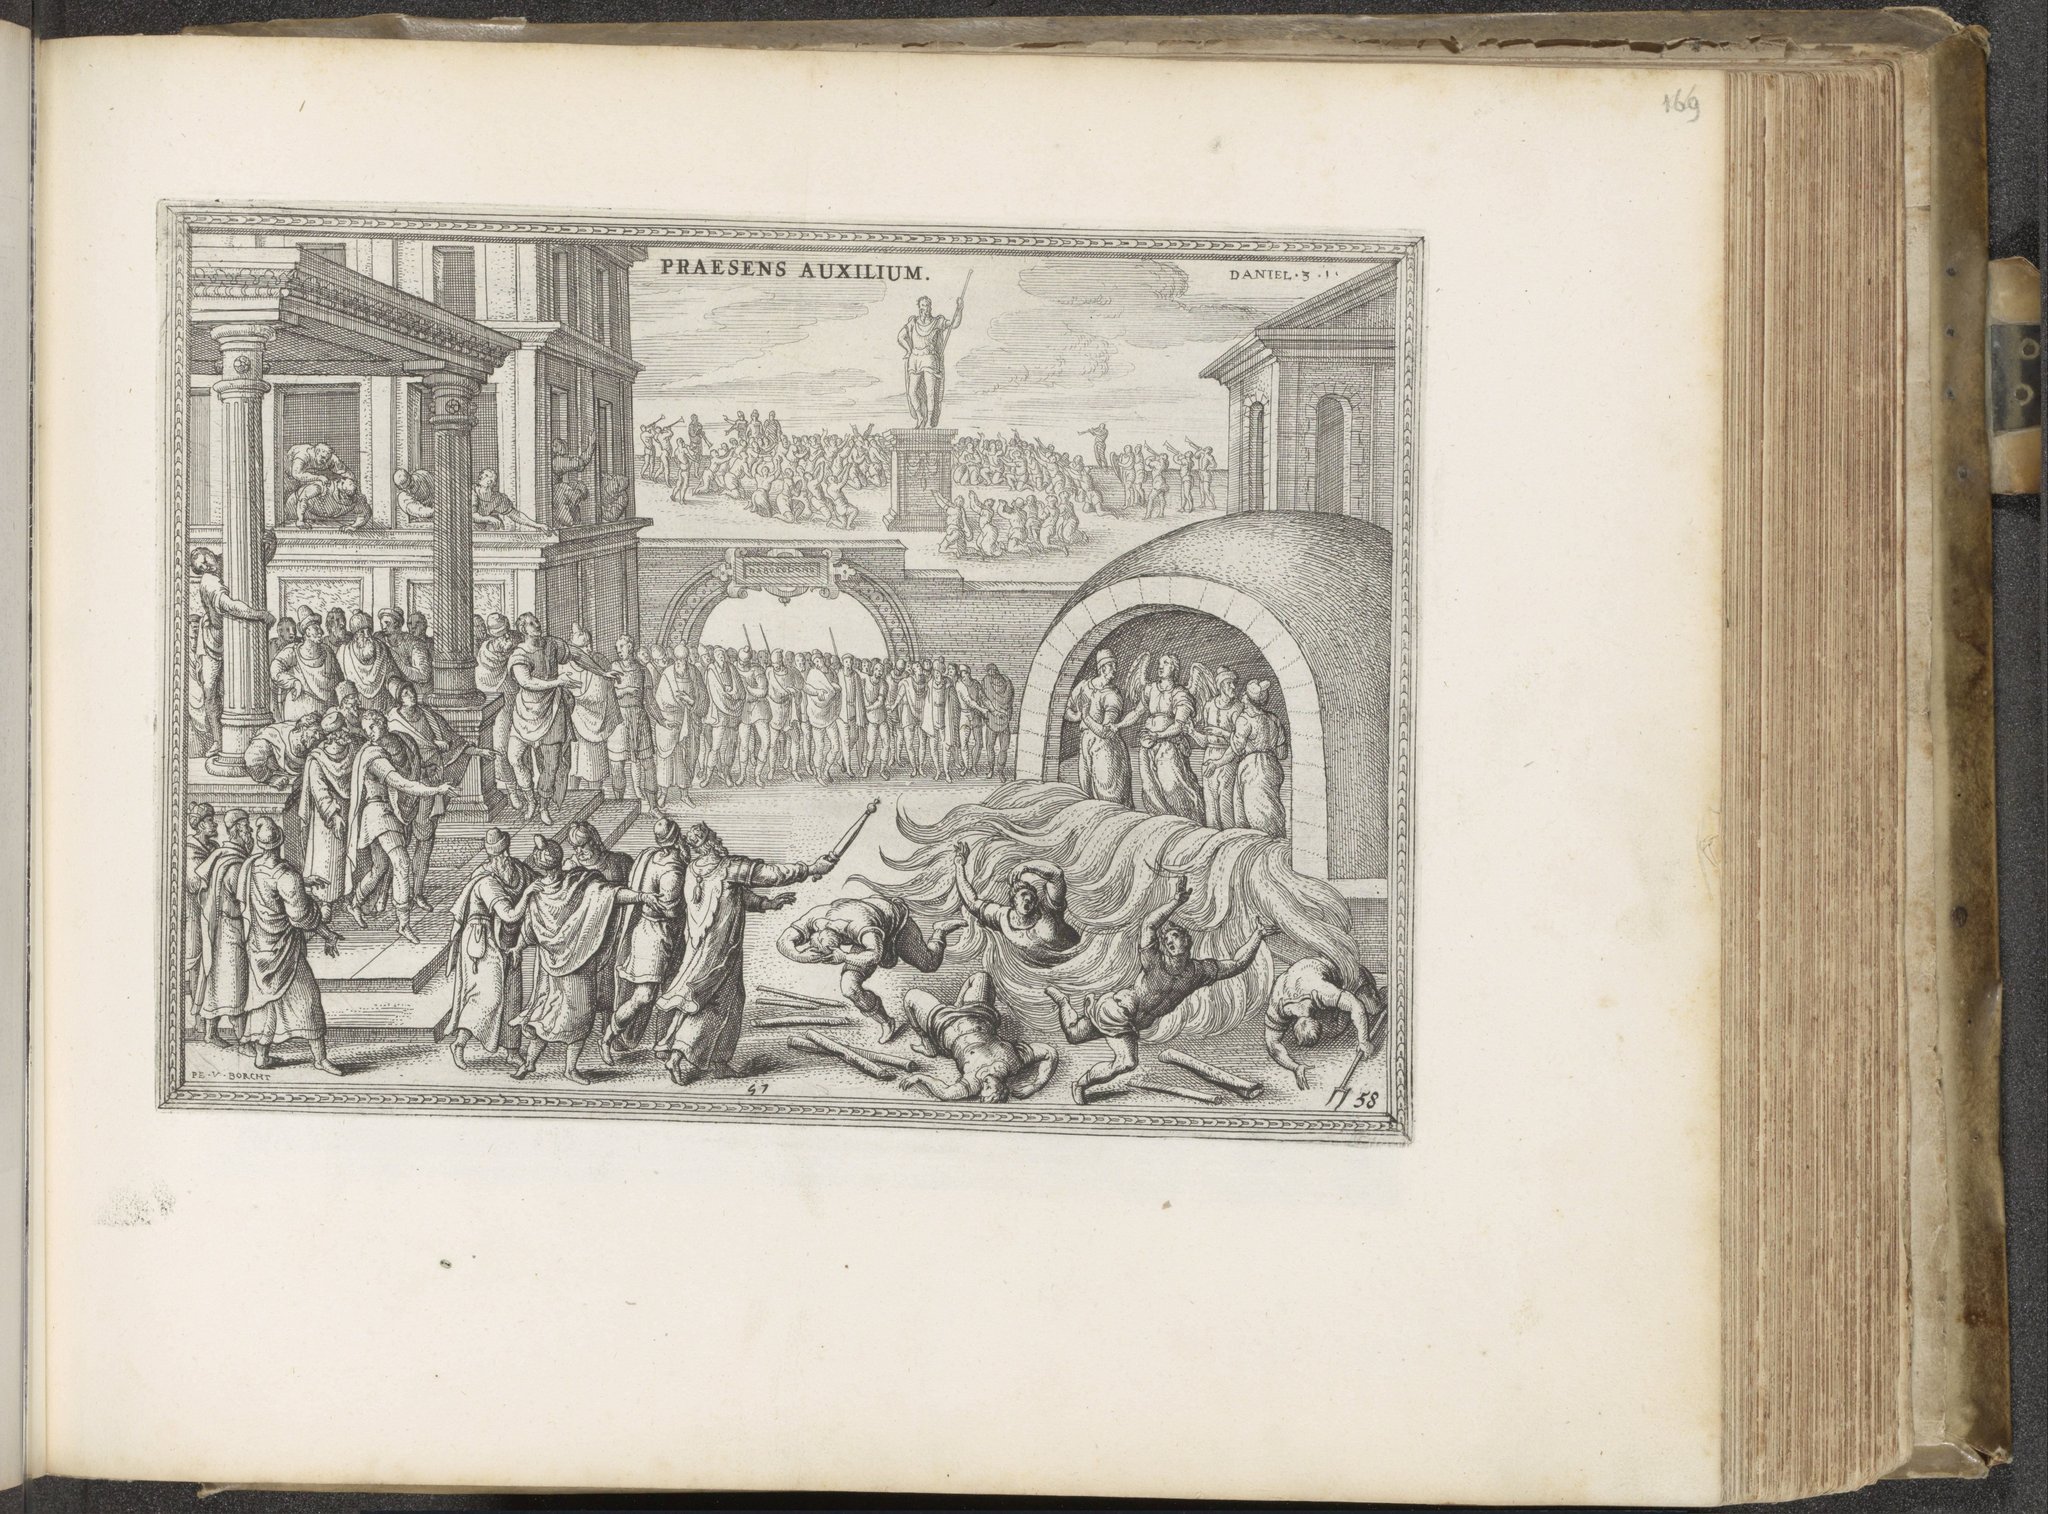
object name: print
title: Drie jongelingen in de brandende oven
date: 1582-1593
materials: paper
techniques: etching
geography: amsterdam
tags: to his astonishment king nebuchadnezzar sees four men (one of them usually represented as an angel) in the furnace; the king commands them to come forth, after the furnace has been heated seven times more, the three hebrews are bound and thrown into the fire; their executioners are burnt by the flames, the dedication of the golden statue: in the presence of king nebuchadnezzar, trumpets are blown and all the people surrounding the image fall on their knees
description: Nebukadnezar heeft de drie jongelingen Shadrach, Mesach en Abednego in een brandende oven laten werpen nadat zij wiegerden een gouden beeld te aanbidden. Een door God gestuurde engel houdt de jongelingen ongedeerd. Omdat het vuur in de oven uitzonderlijk heet was gestookt, werden de mannen die de drie naar de oven brachten door de uitslaande vlammen gedood (Dan. 5:1). De prent maakt deel uit van een album.